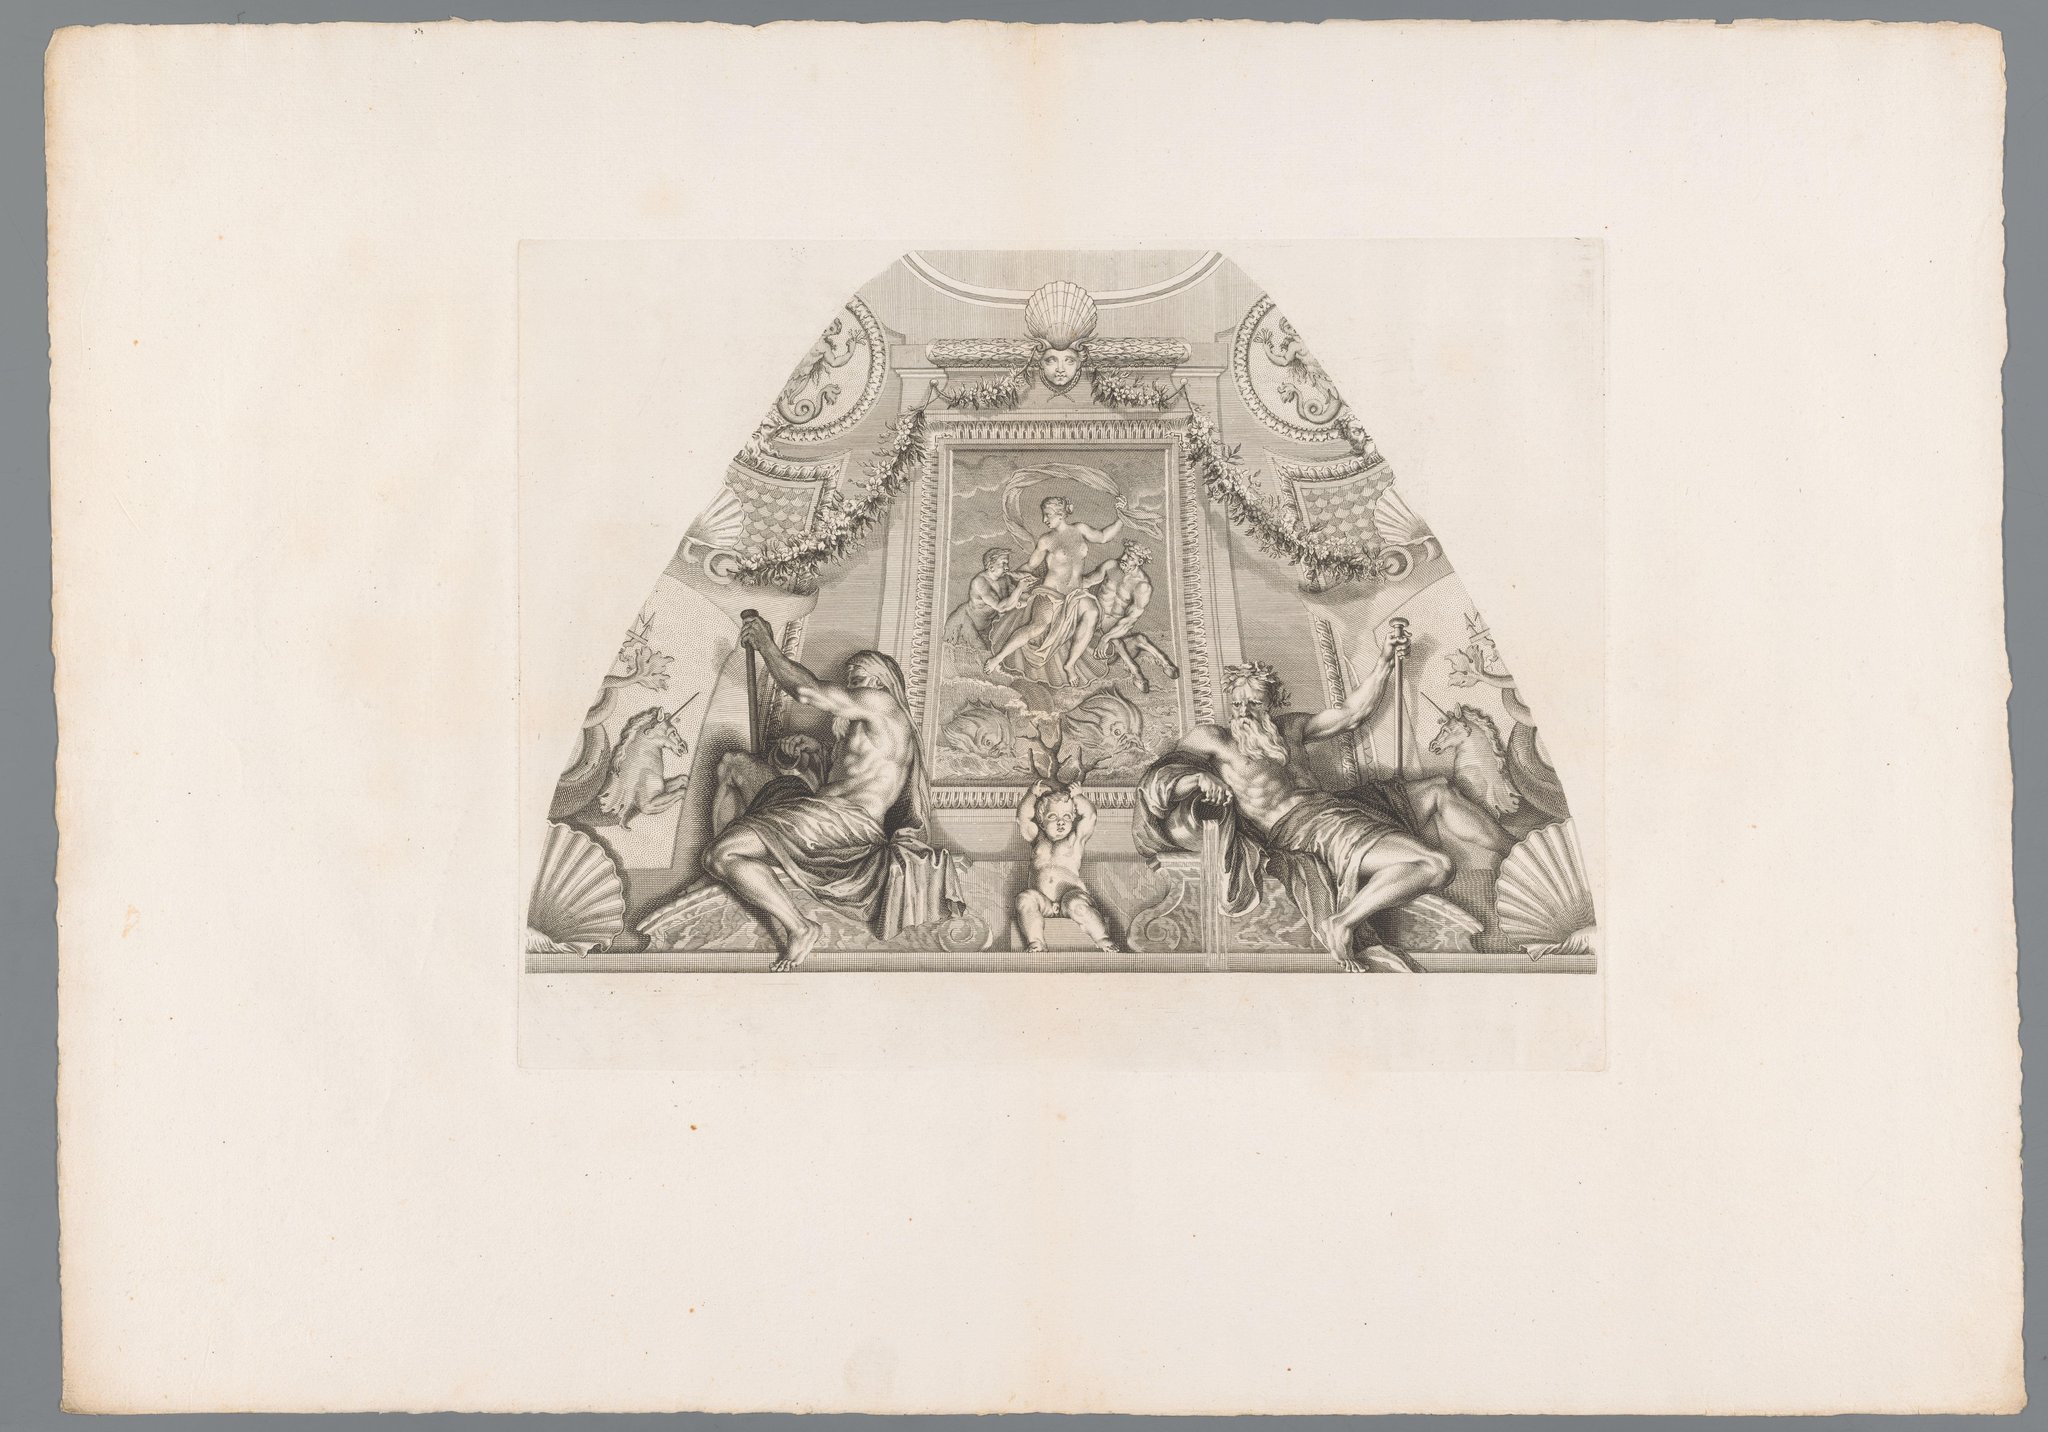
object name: print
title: Les peintures de Charles le Brun et d'Eustache Le Sueur qui sont dans (...) la maison du Président Lambert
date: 1740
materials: paper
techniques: engraving, etching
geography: paris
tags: triumph of neptune and amphitrite, with a retinue of tritons and nereids, i.e. marriage train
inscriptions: collector's mark: Lugt 2228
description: Grisaille, met de voorstelling van Amphitrite gezeten in een door dolfijnen getrokken schelp en begeleidt door tritons, in de hoek van het plafond van de Chambre des Bains in het Hôtel Lambert. De voorstelling van Amphitrite wordt geflankeerd door twee stroomgoden, ieder met een waterkan. Midden onder een putto met een gewei van koraal op het hoofd. Prent maakt deel uit van een serie prenten naar de schilderijen in het Hôtel Lambert te Parijs.